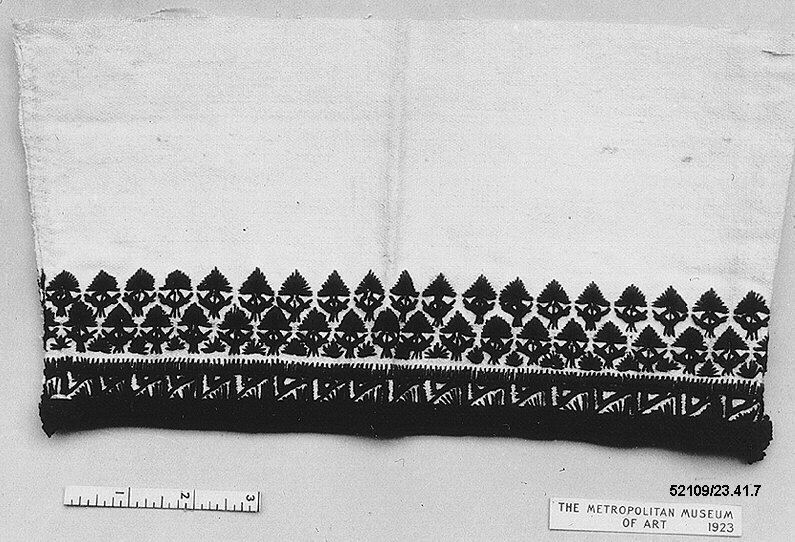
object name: cuff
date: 1801-1900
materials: cotton